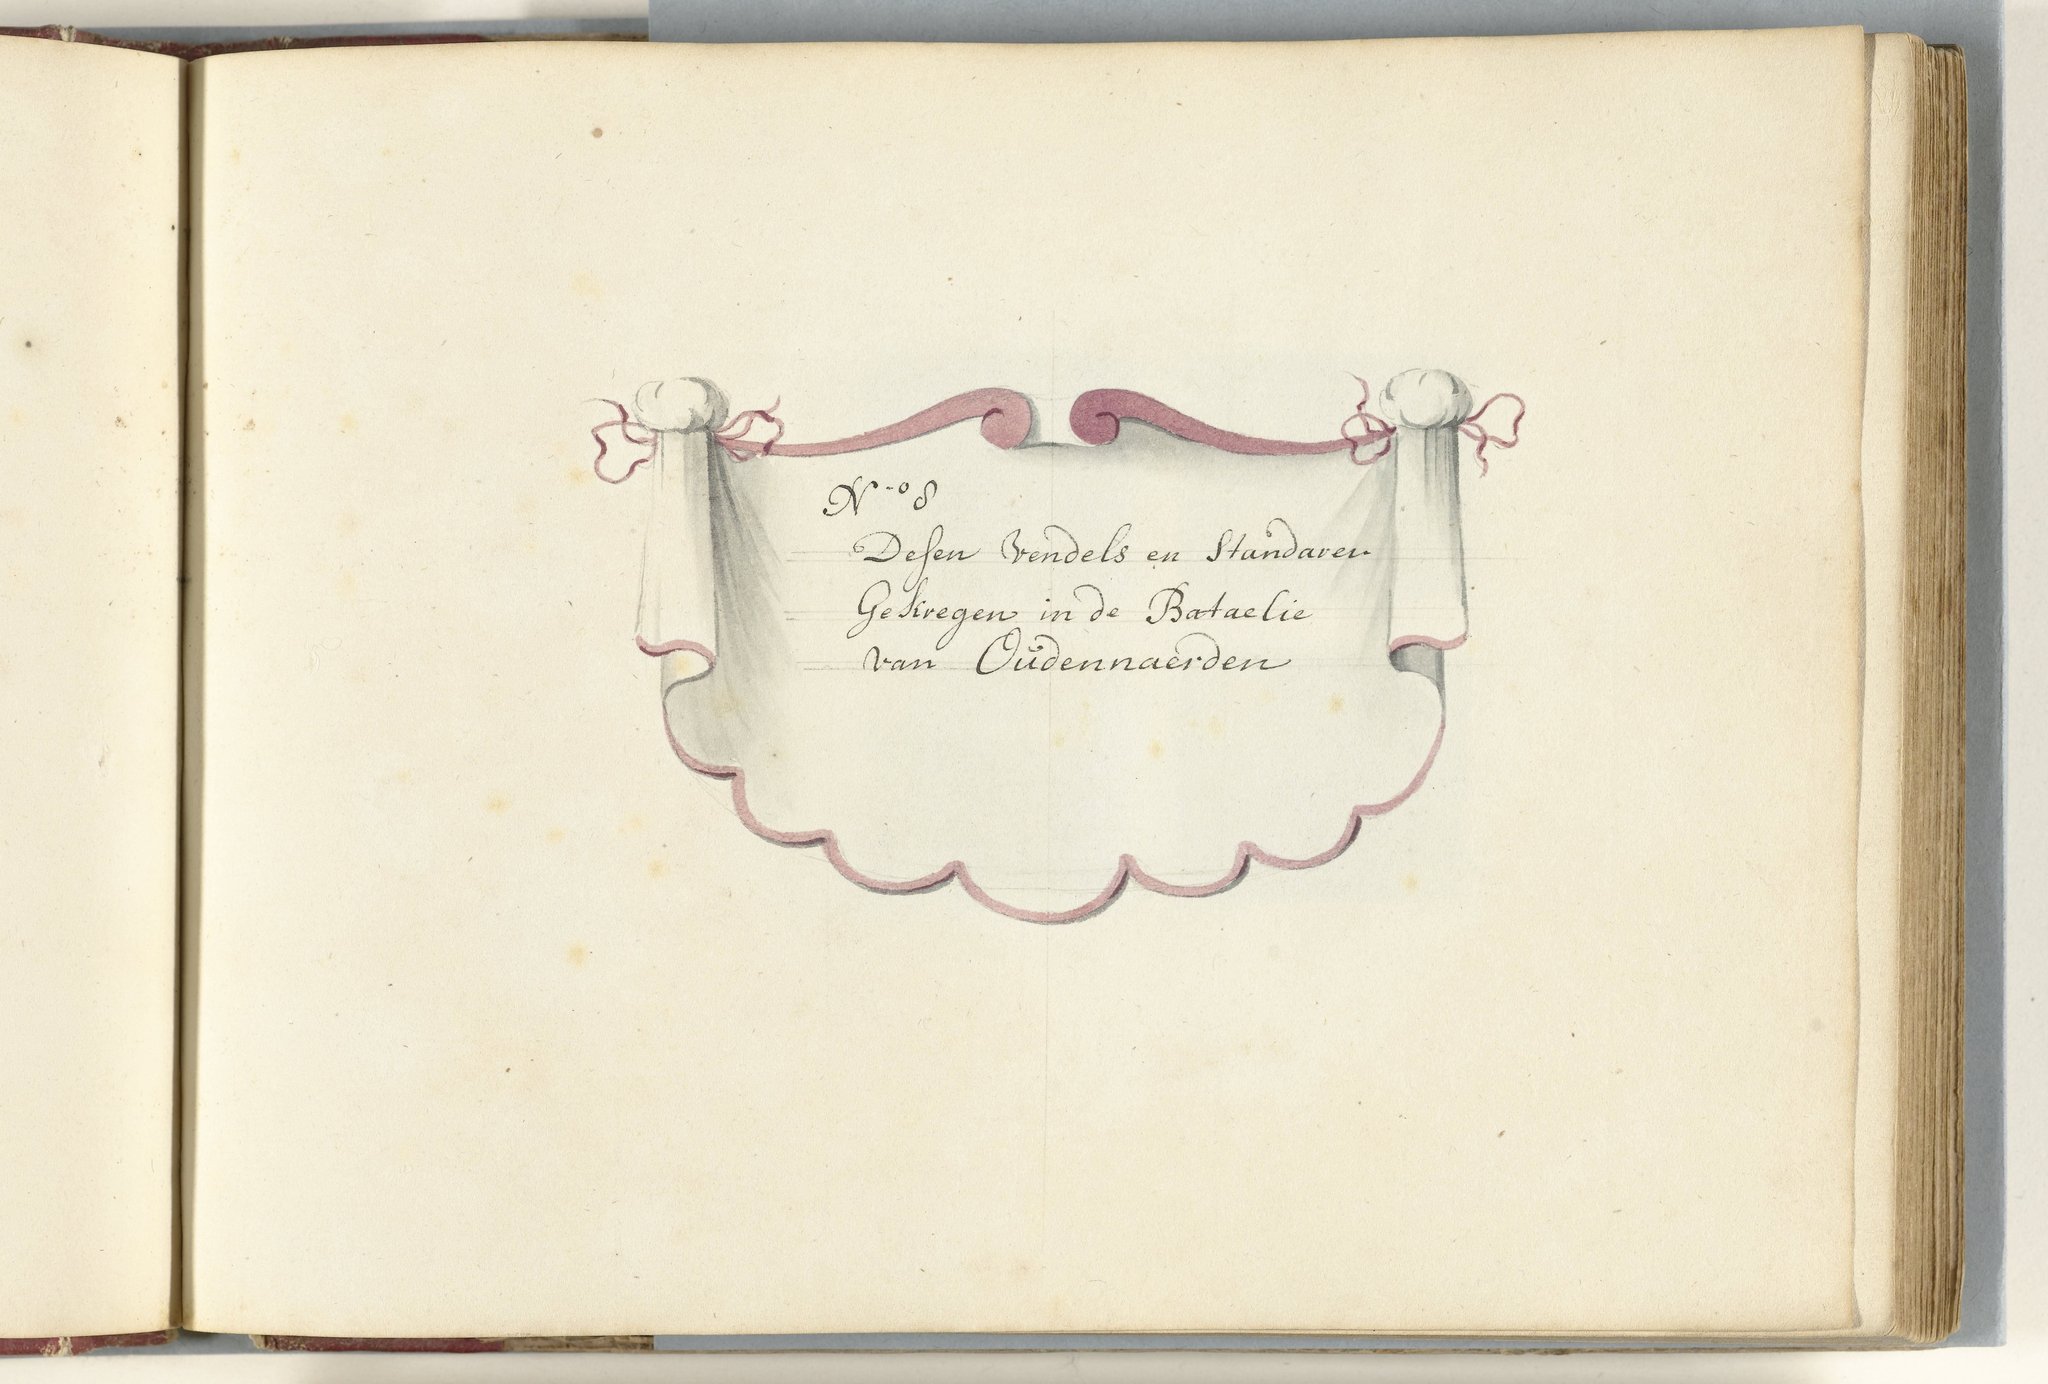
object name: drawing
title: Serietitel voor de groep vaandels veroverd in de slag bij Oudenaarde, 1708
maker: Anonymous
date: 1713-1720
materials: paper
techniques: drawing, writing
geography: northern netherlands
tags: spaanse successieoorlog, slag bij oudenaarde (1708)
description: Cartouche met de serietitel voor de groep van Franse vaandels en standaarden veroverd bij de slag bij Oudenaarde in 1708. In het boek met tekeningen van Franse vaandels, standaarden en pauken, veroverd tijdens de Spaanse Successieoorlog (1701-1713).